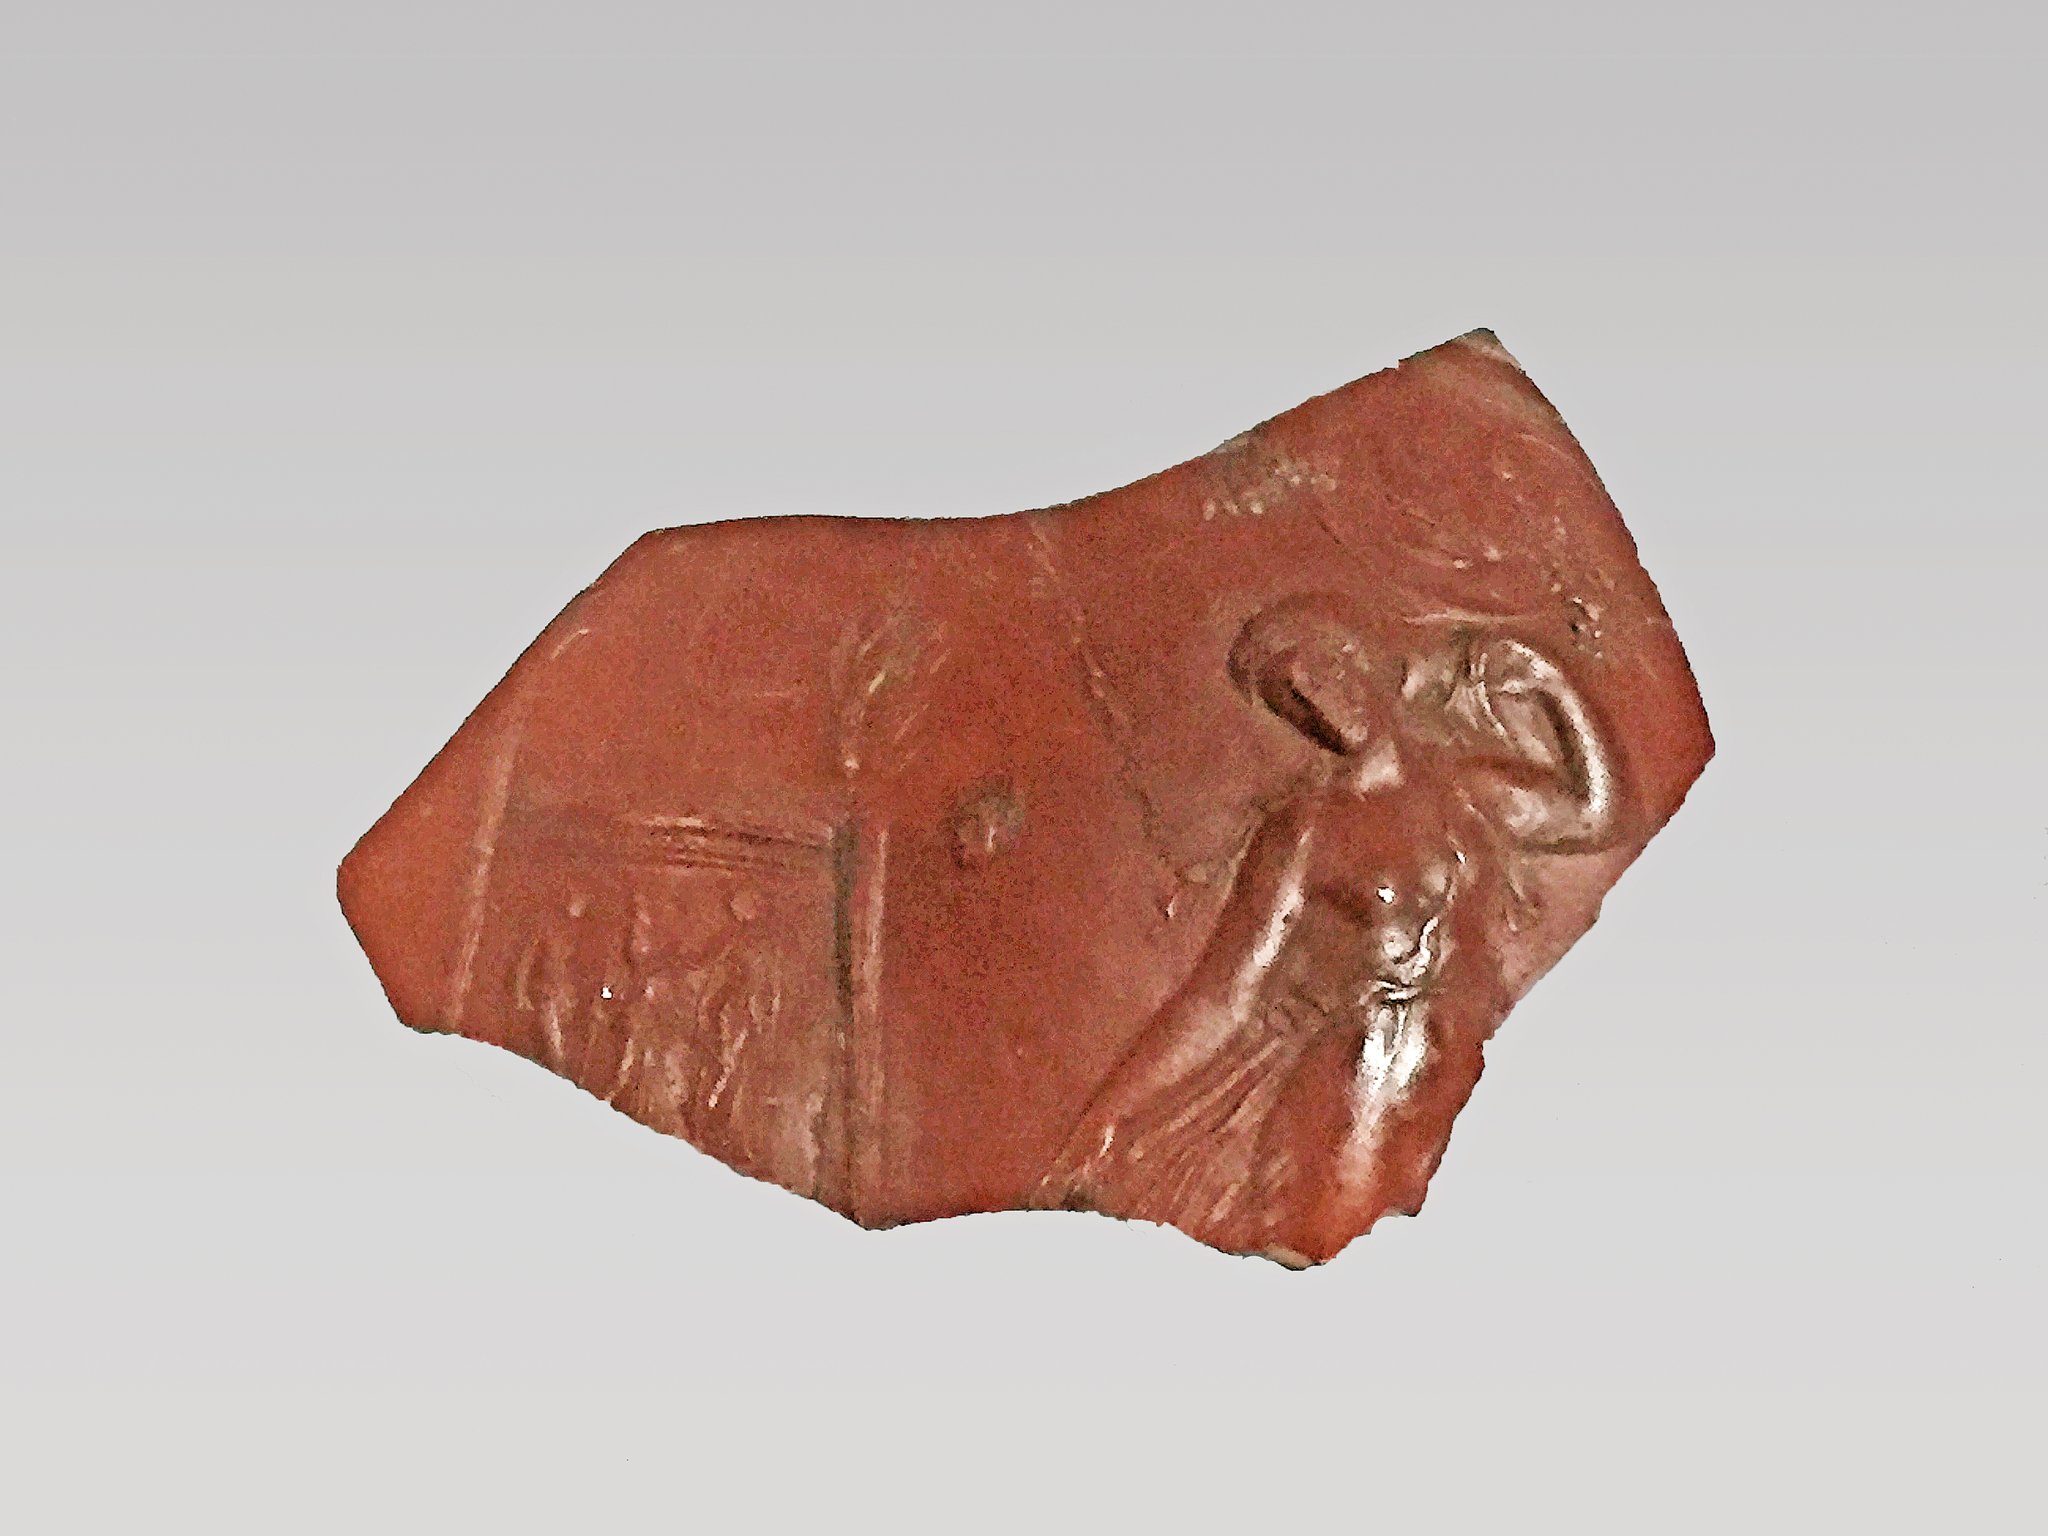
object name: vase fragment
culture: roman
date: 31 BCE-14 CE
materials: terracotta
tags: altars,dancing,maenads